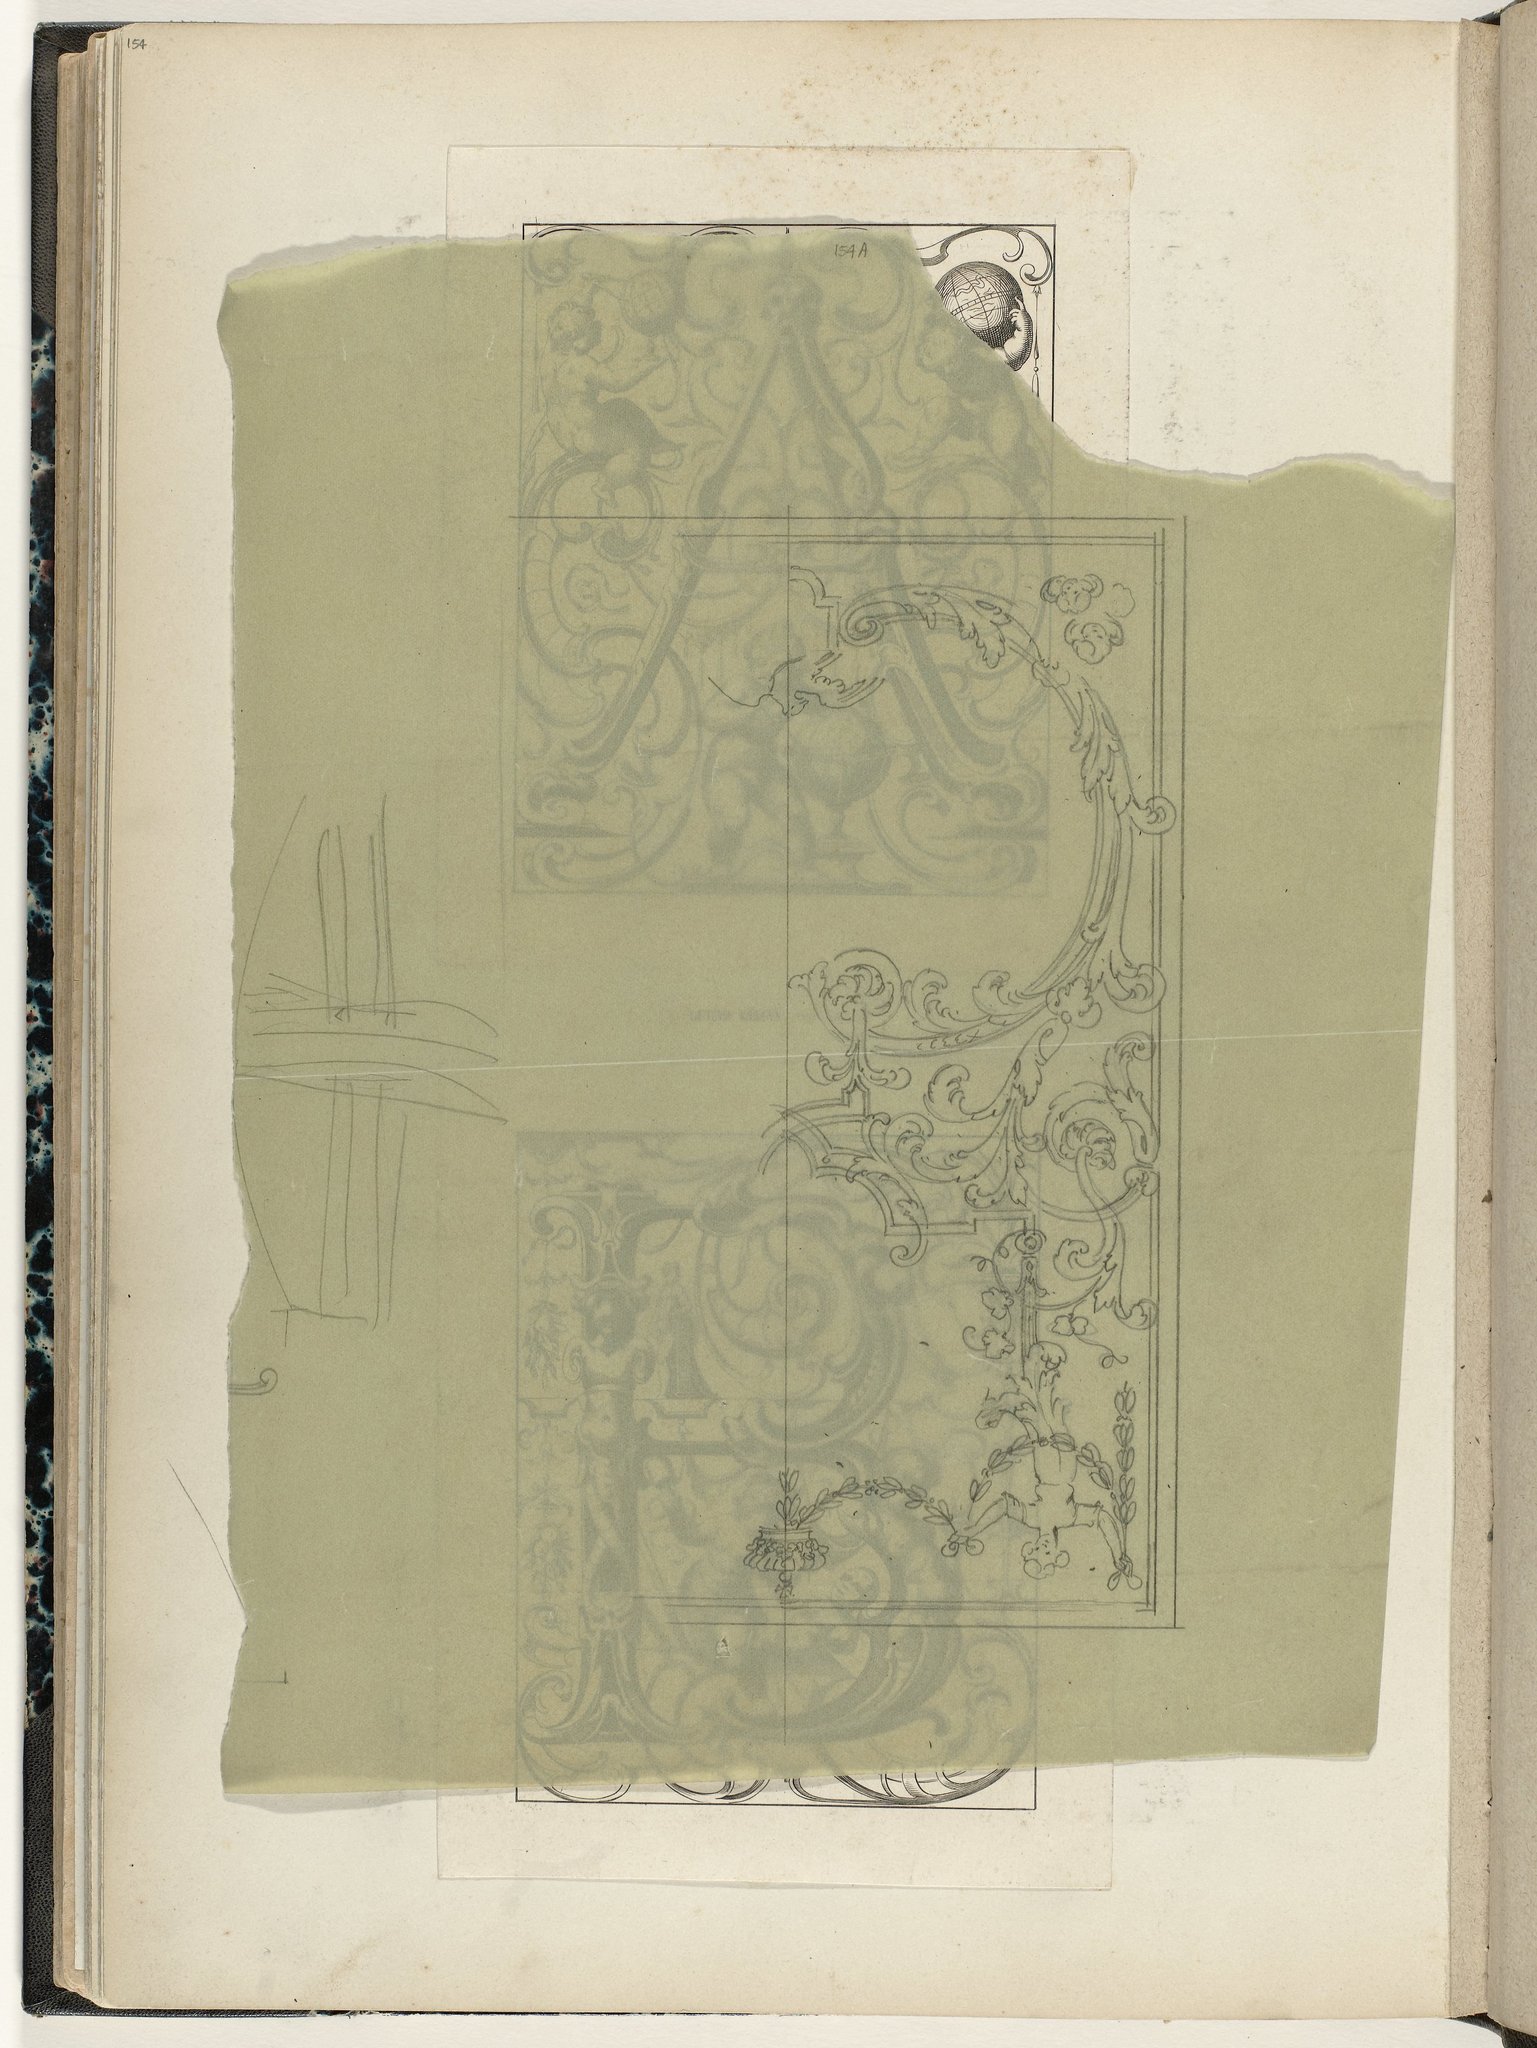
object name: drawing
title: Half paneel met cartouche en gevleugelde vrouw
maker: Anonymous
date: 1866-1900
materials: paper, pencil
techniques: drawing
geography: netherlands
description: Linksboven bevindt zich het bovenlichaam van een gevleugelde vrouw die een guirlande vasthoudt, midden boven hangt een kroon. Onderaan is de helft van een cartouche met bladranken zichtbaar.